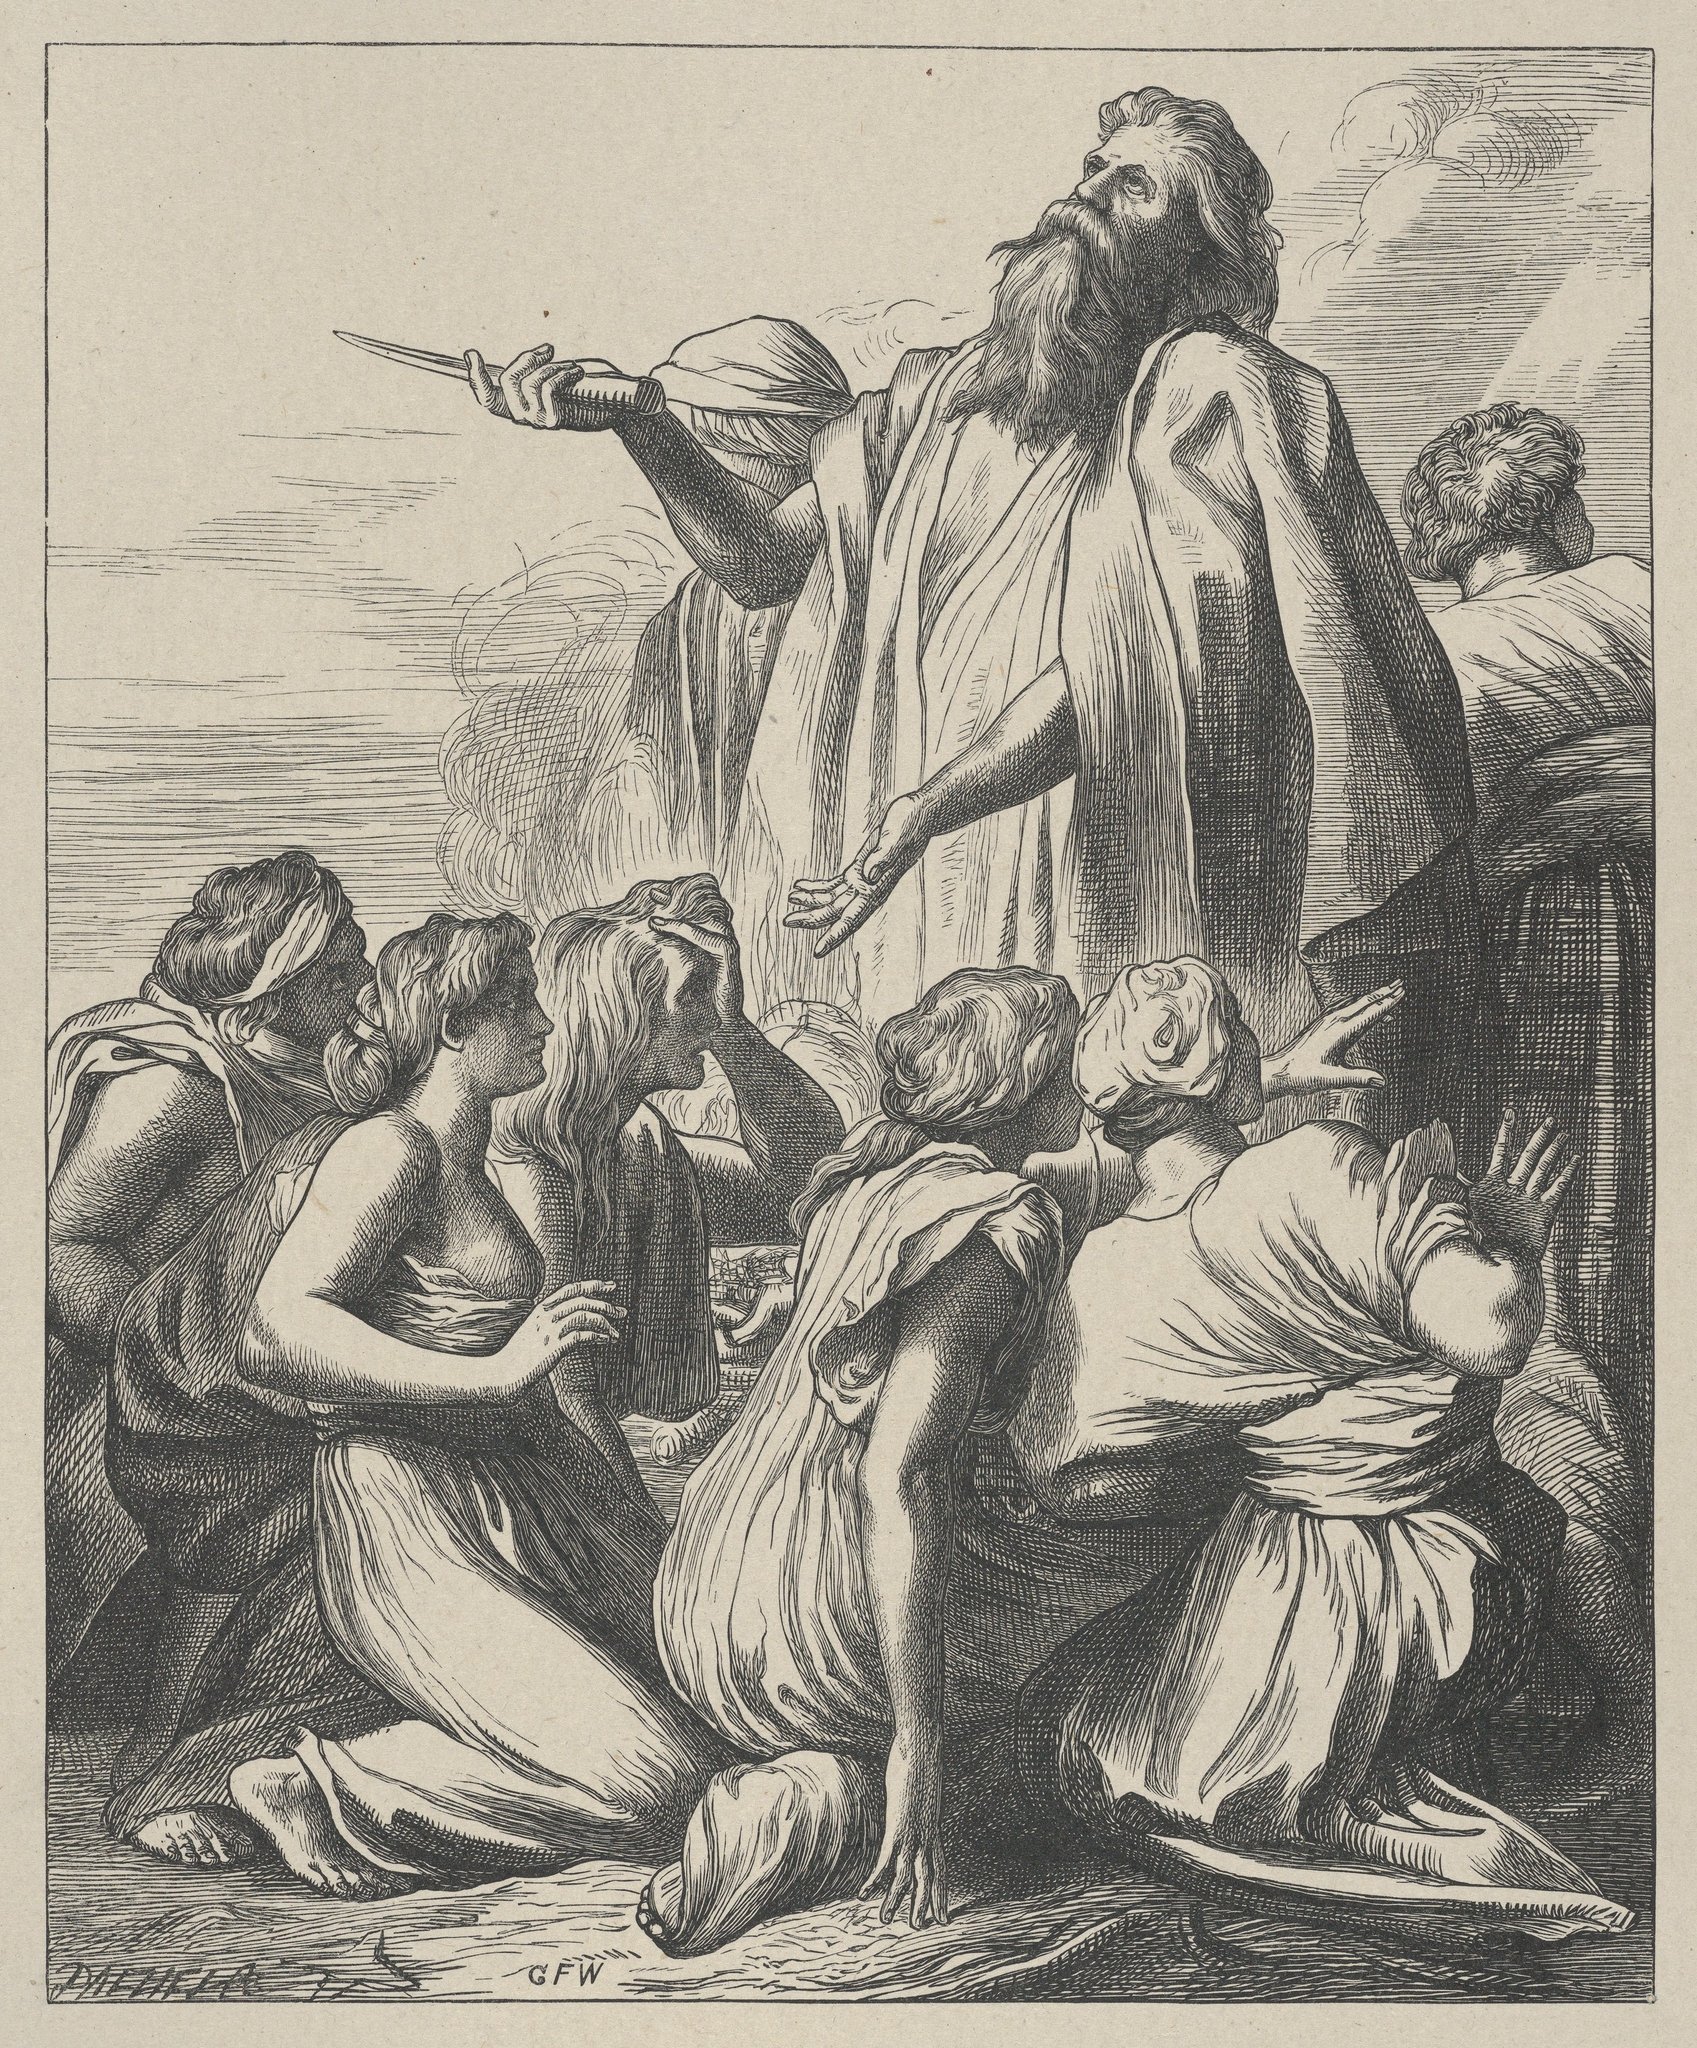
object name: print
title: Noah's Sacrifice, from "Dalziels' Bible Gallery"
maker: george frederic watts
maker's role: artist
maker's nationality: british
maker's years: 1817-1904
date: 1881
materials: paper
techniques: engraving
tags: men,women